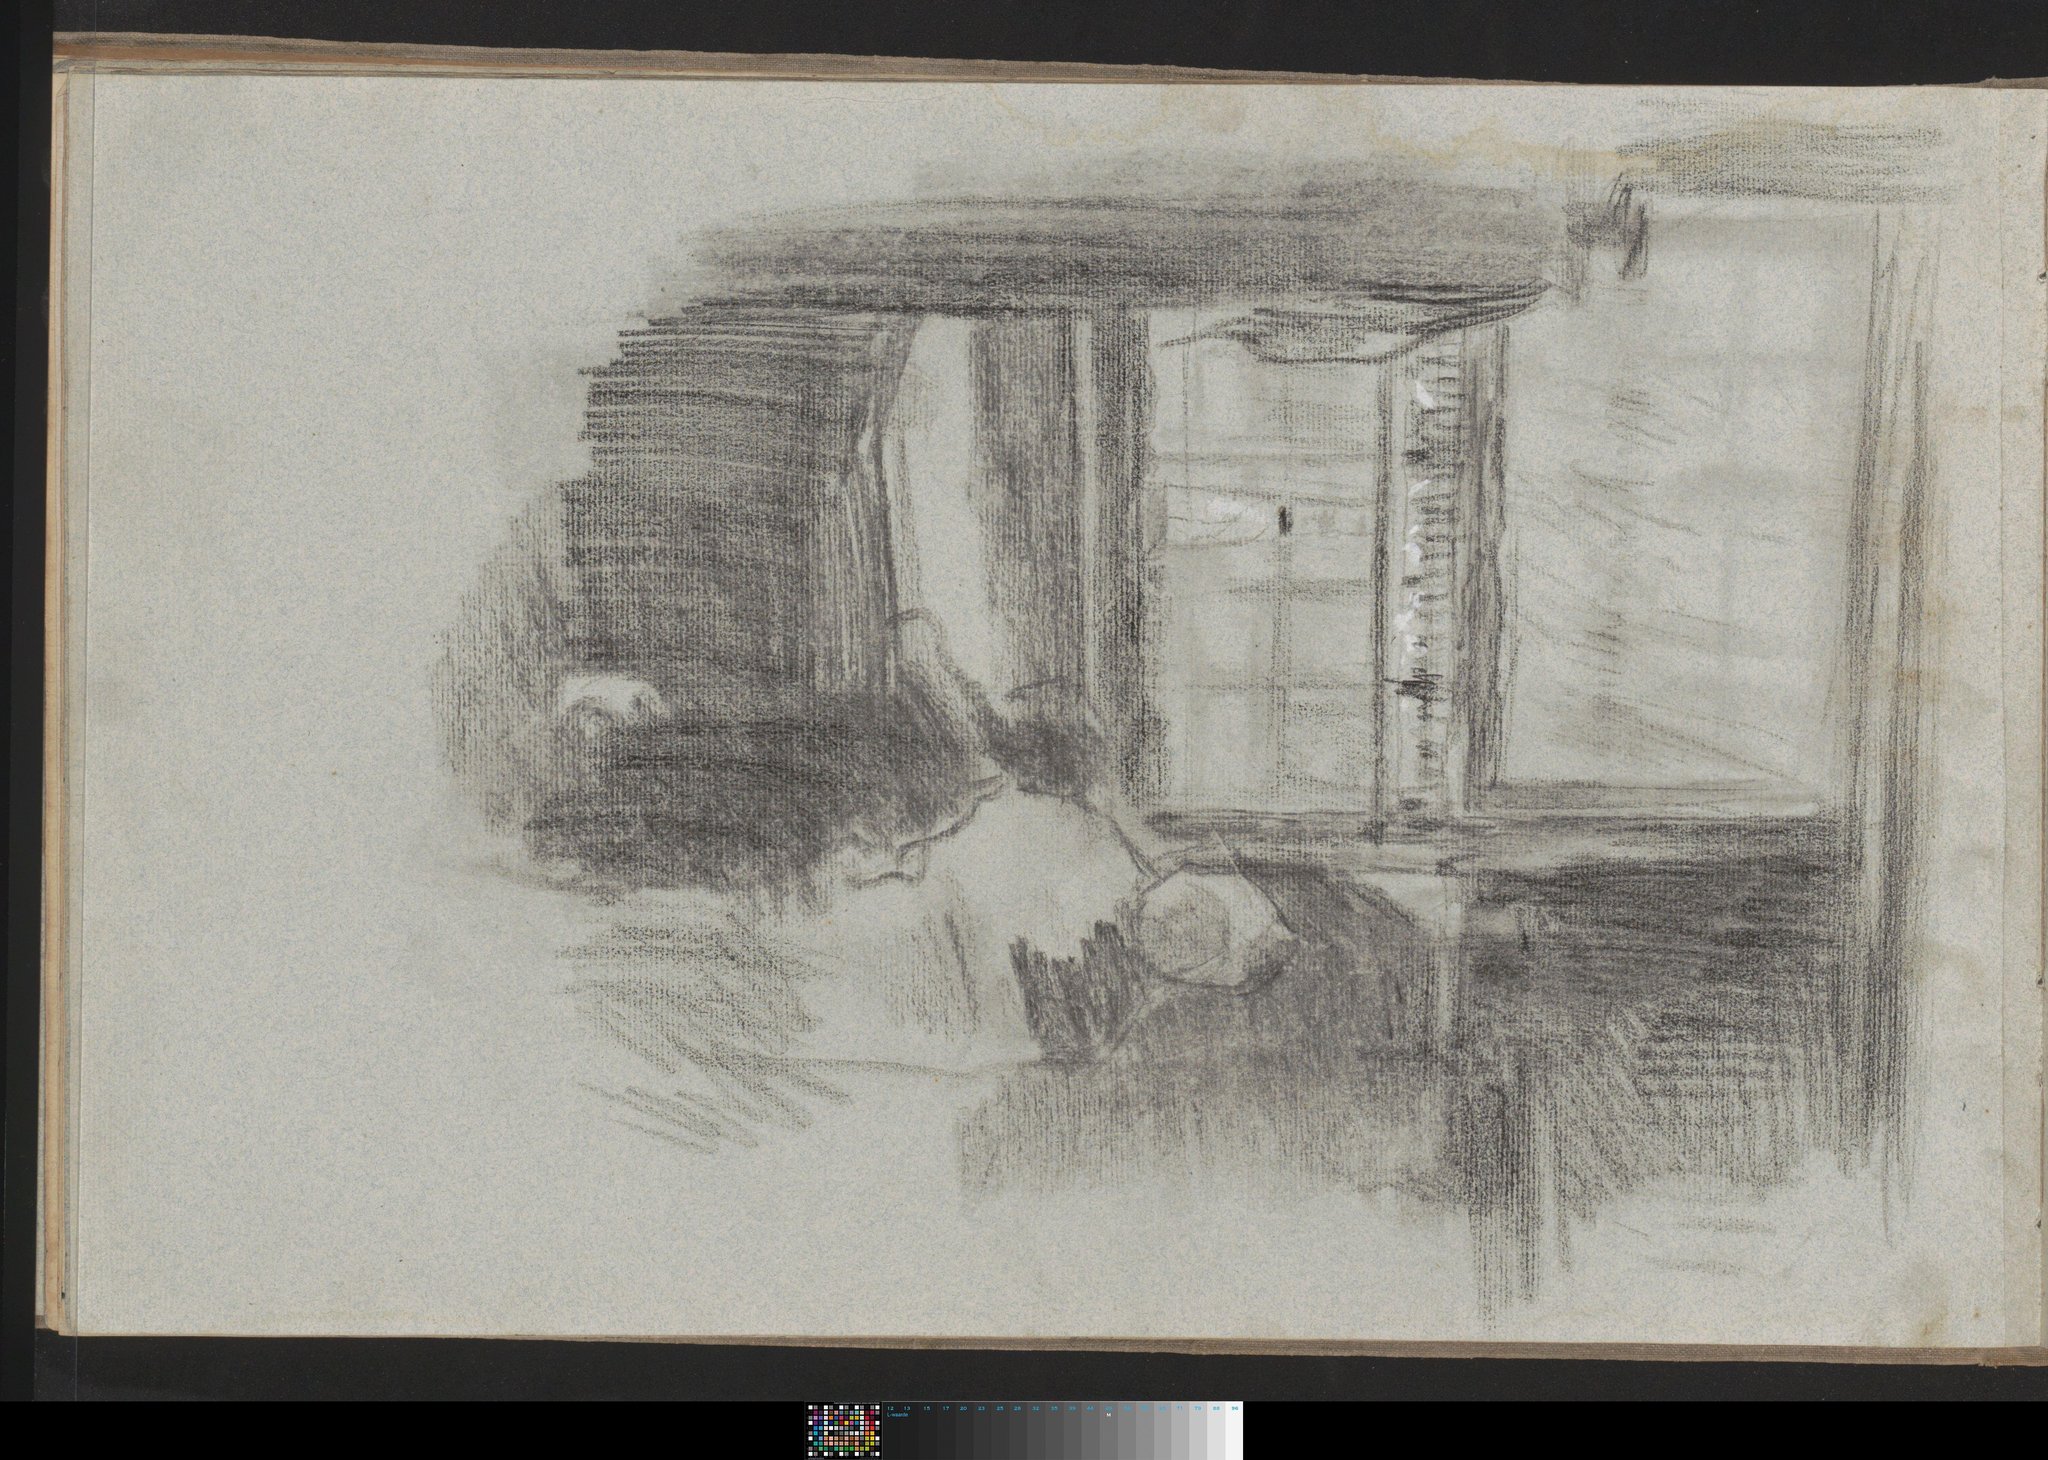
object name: sketchbook leaf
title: Interieur met een handwerkende vrouw bij een raam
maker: albert neuhuys (1844-1914)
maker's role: draughtsman, painter, print maker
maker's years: 1844-1914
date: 1854-1914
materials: charcoal, paint, paper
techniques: brush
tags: sitting figure, adult woman, window, interior of the house, home sewing; repair of clothes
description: Blad 26 verso uit een schetsboek met 51 bladen.